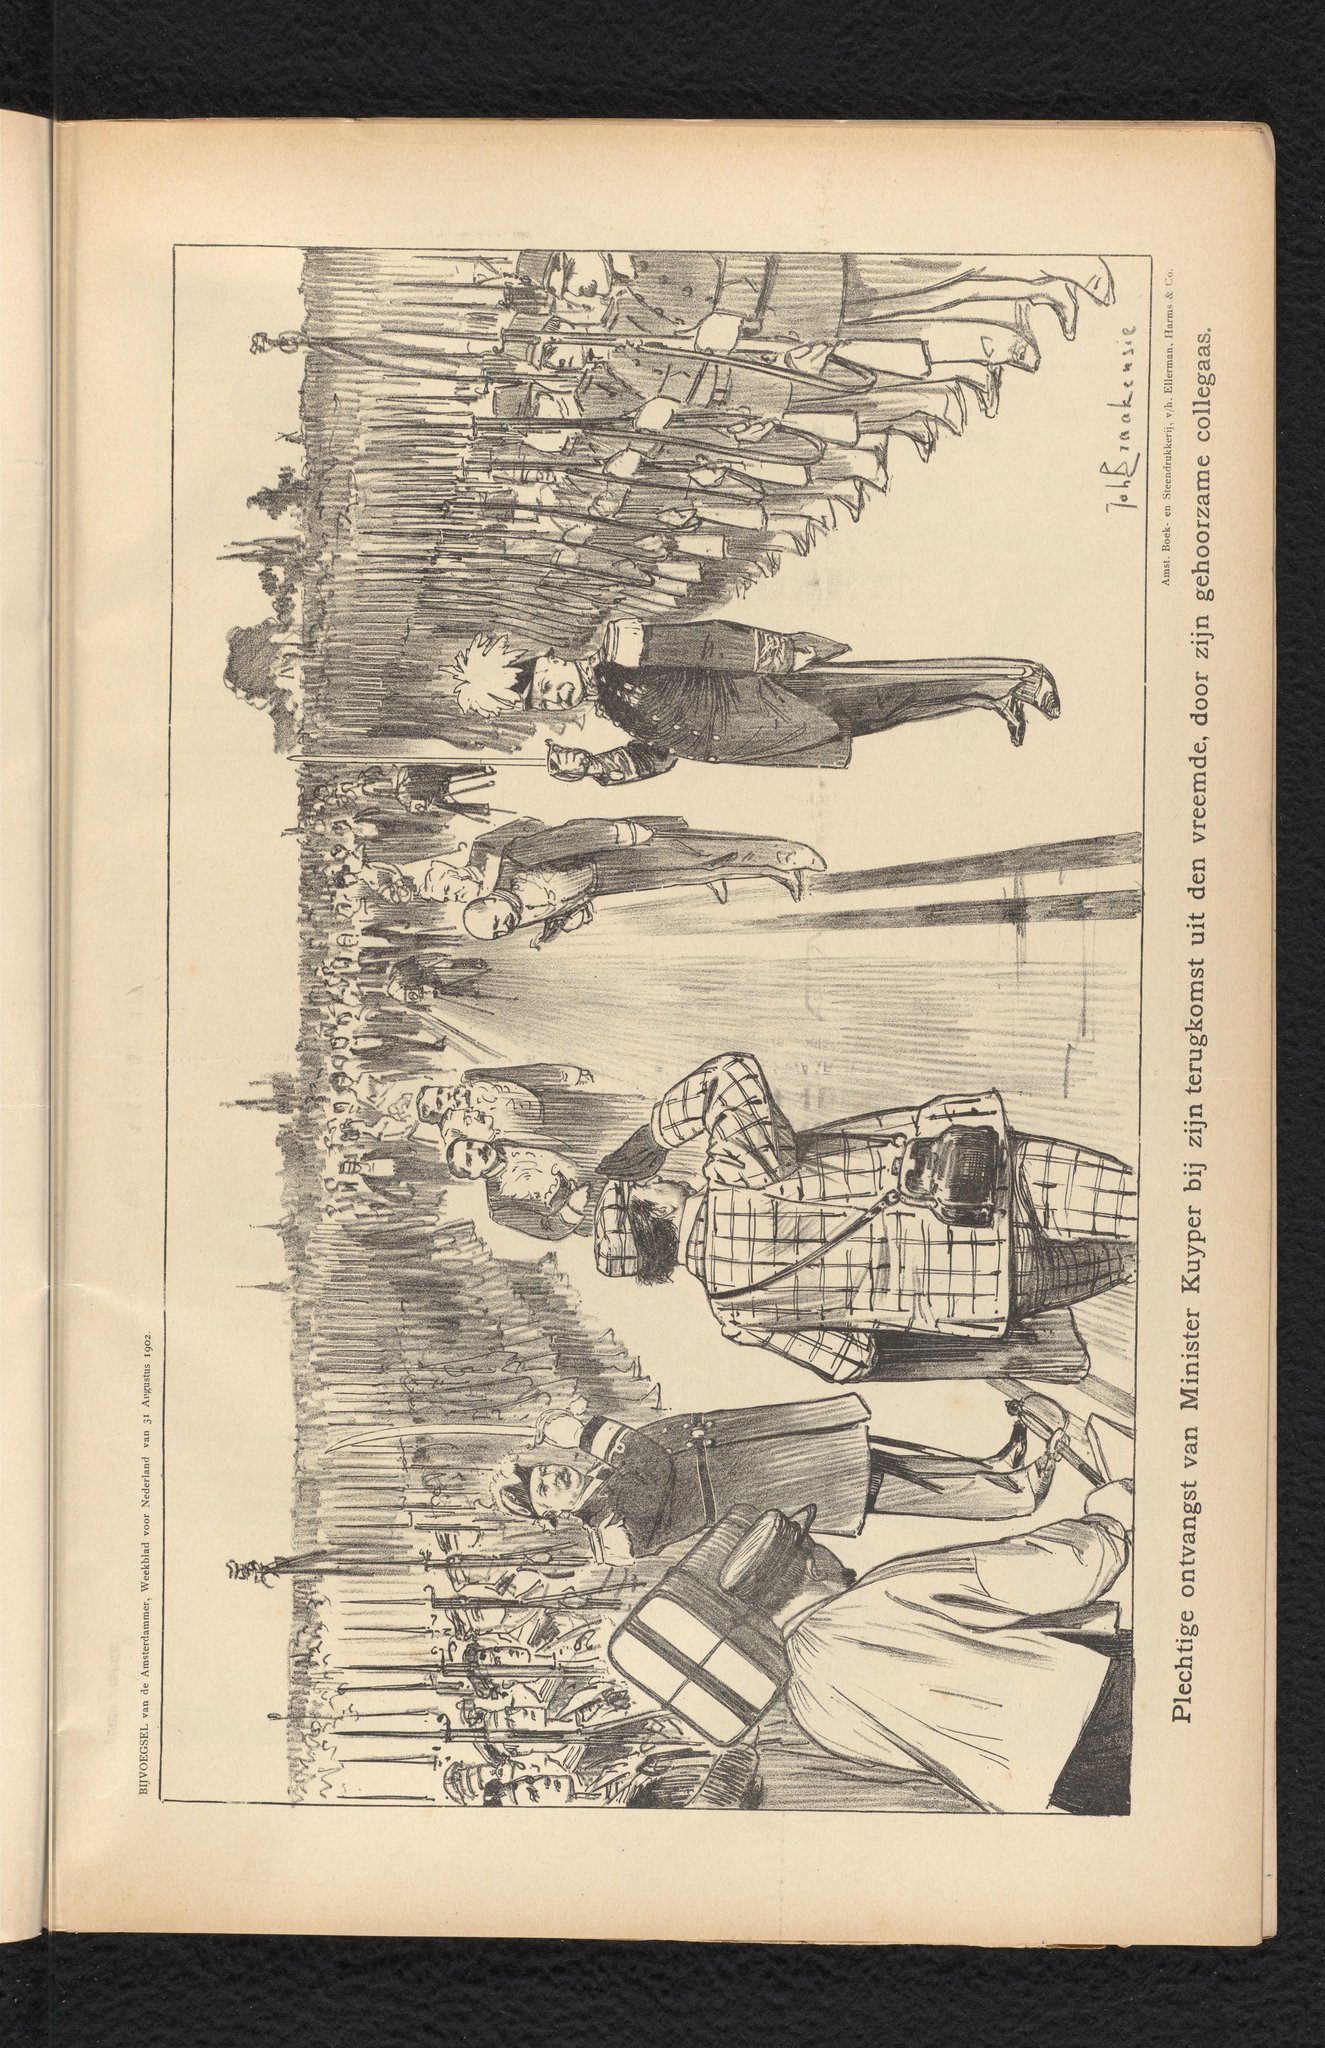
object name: cartoon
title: Plechtige ontvangst van Minister Kuyper bij zijn terugkomst uit den vreemde, door zijn gehoorzame collegaas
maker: johan braakensiek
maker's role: draughtsman, print maker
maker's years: 1858-1940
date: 1902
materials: paper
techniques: lithograph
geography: amsterdam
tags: the hague, abraham kuyper, being welcomed ~ travelling, saluting, political caricatures and satires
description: Premier Kuyper wordt bij terugkomst in Nederland met ceremonieel onthaal begroet door de ministers van zijn kabinet, opgestelde troepen, persfotografen en feestelijk aangeklede bevolking.